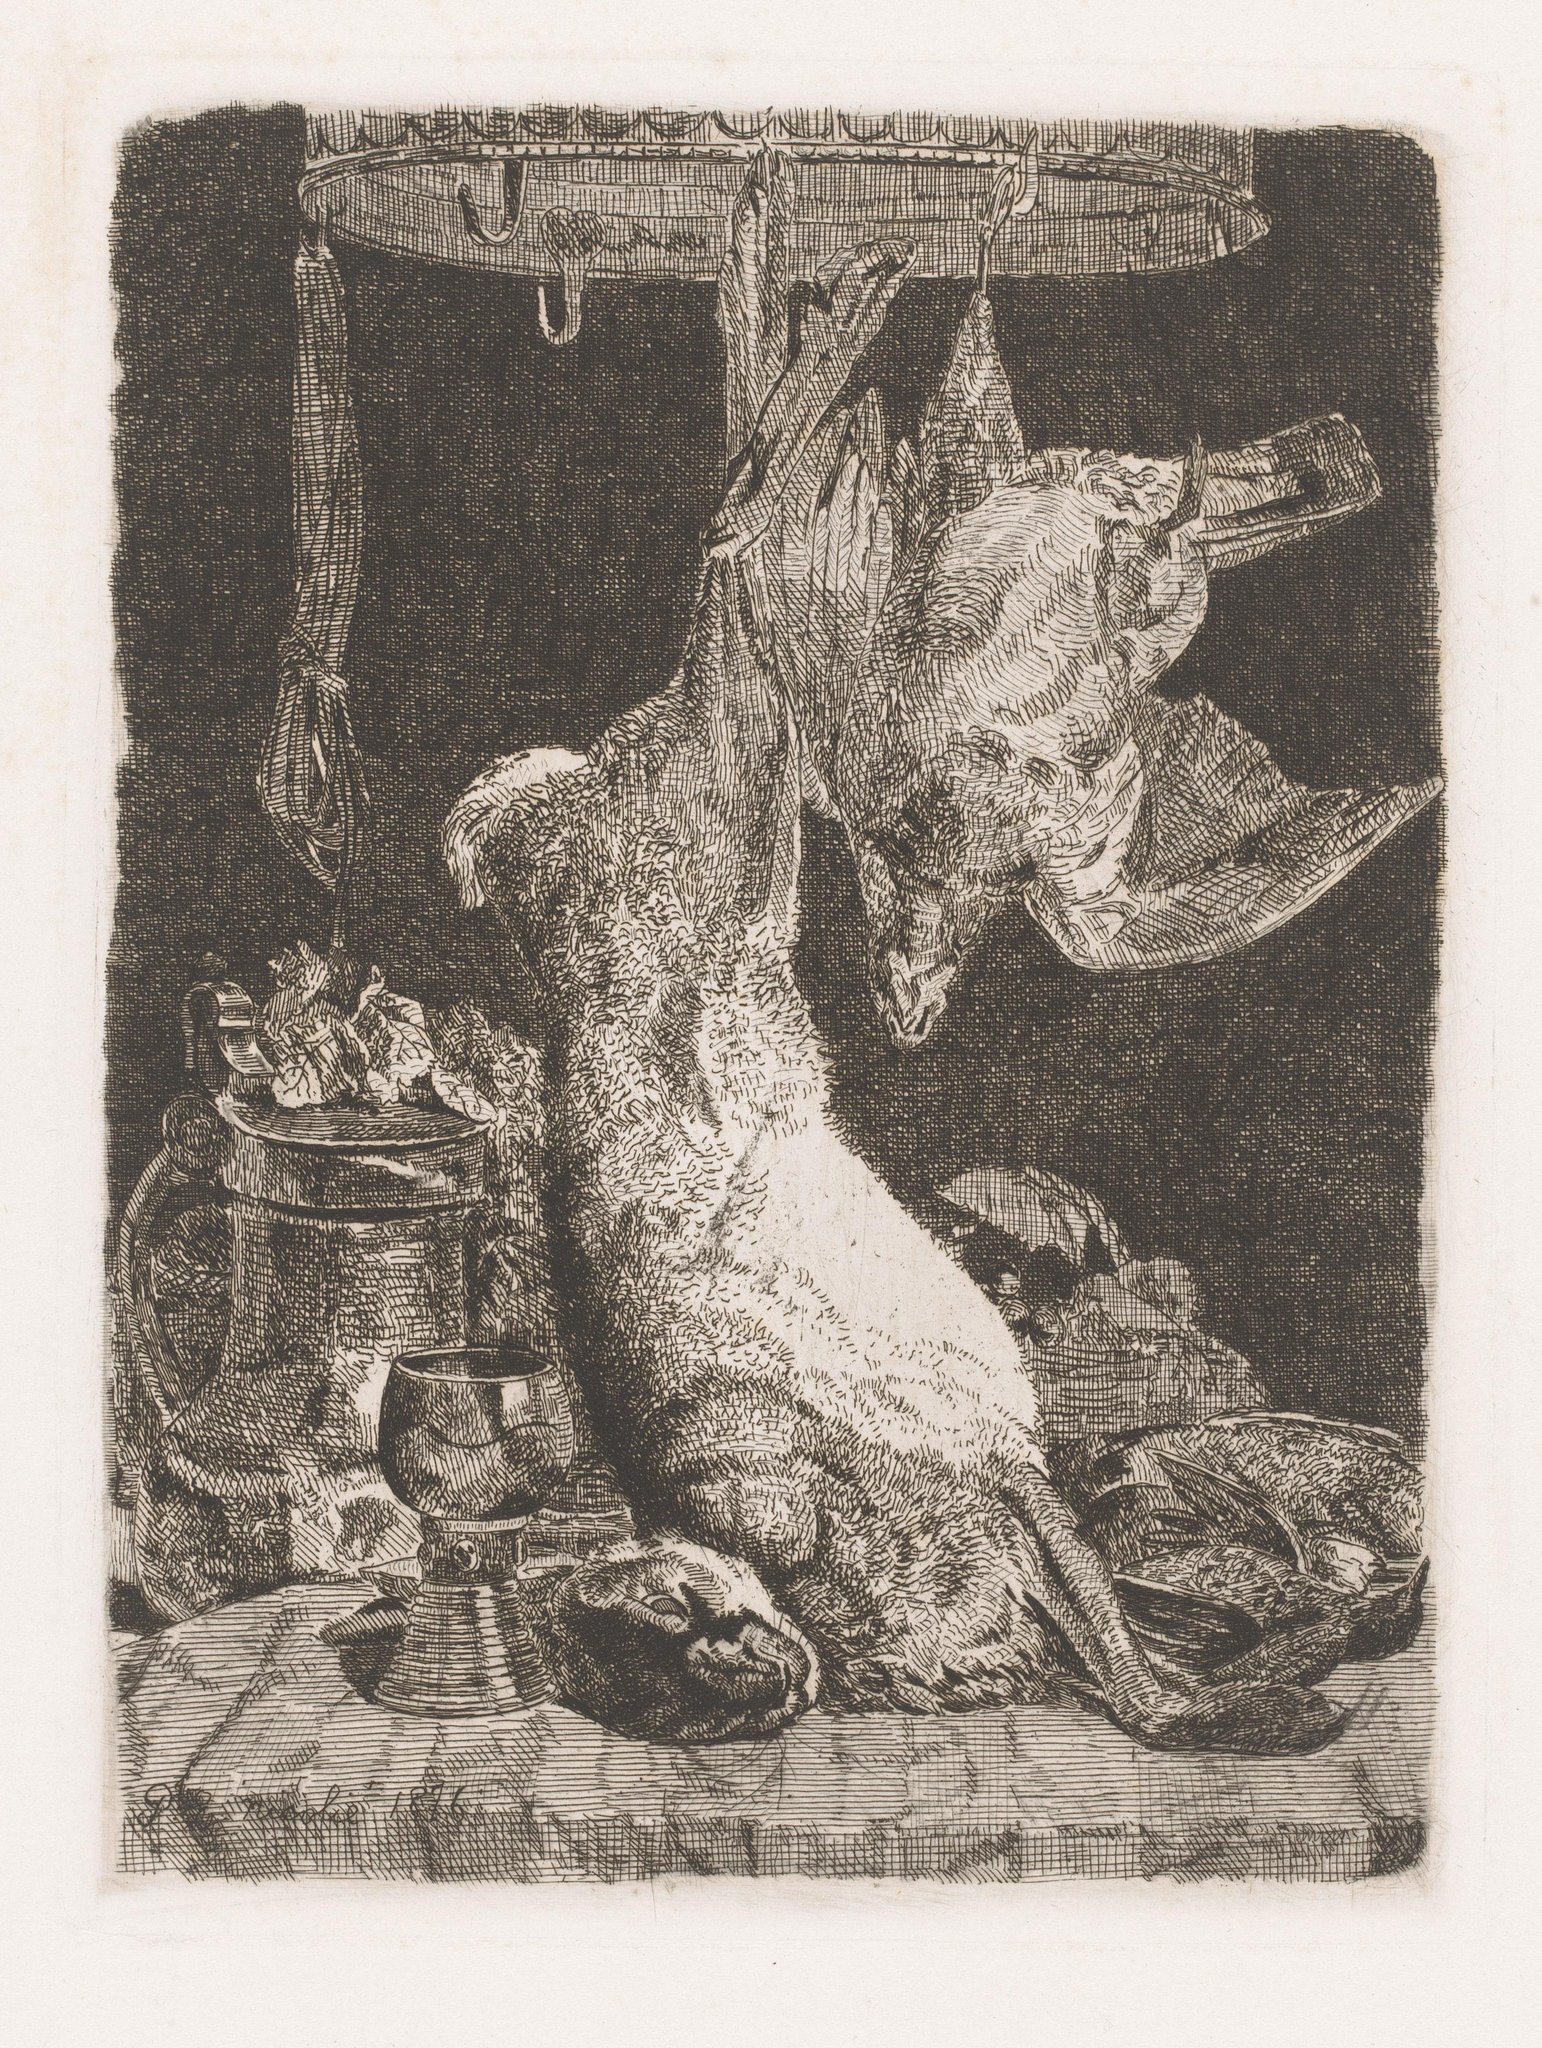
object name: print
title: Stilleven met een haas en patrijs aan een wildkroon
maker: paul emile nicolié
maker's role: print maker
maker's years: 1828-1894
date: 1876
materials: paper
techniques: etching, intaglio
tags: rodents: hare, walker and runner birds: partridge, hunting trophies, foodstuffs; still life of foodstuffs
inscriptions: collector's mark: Lugt 2228